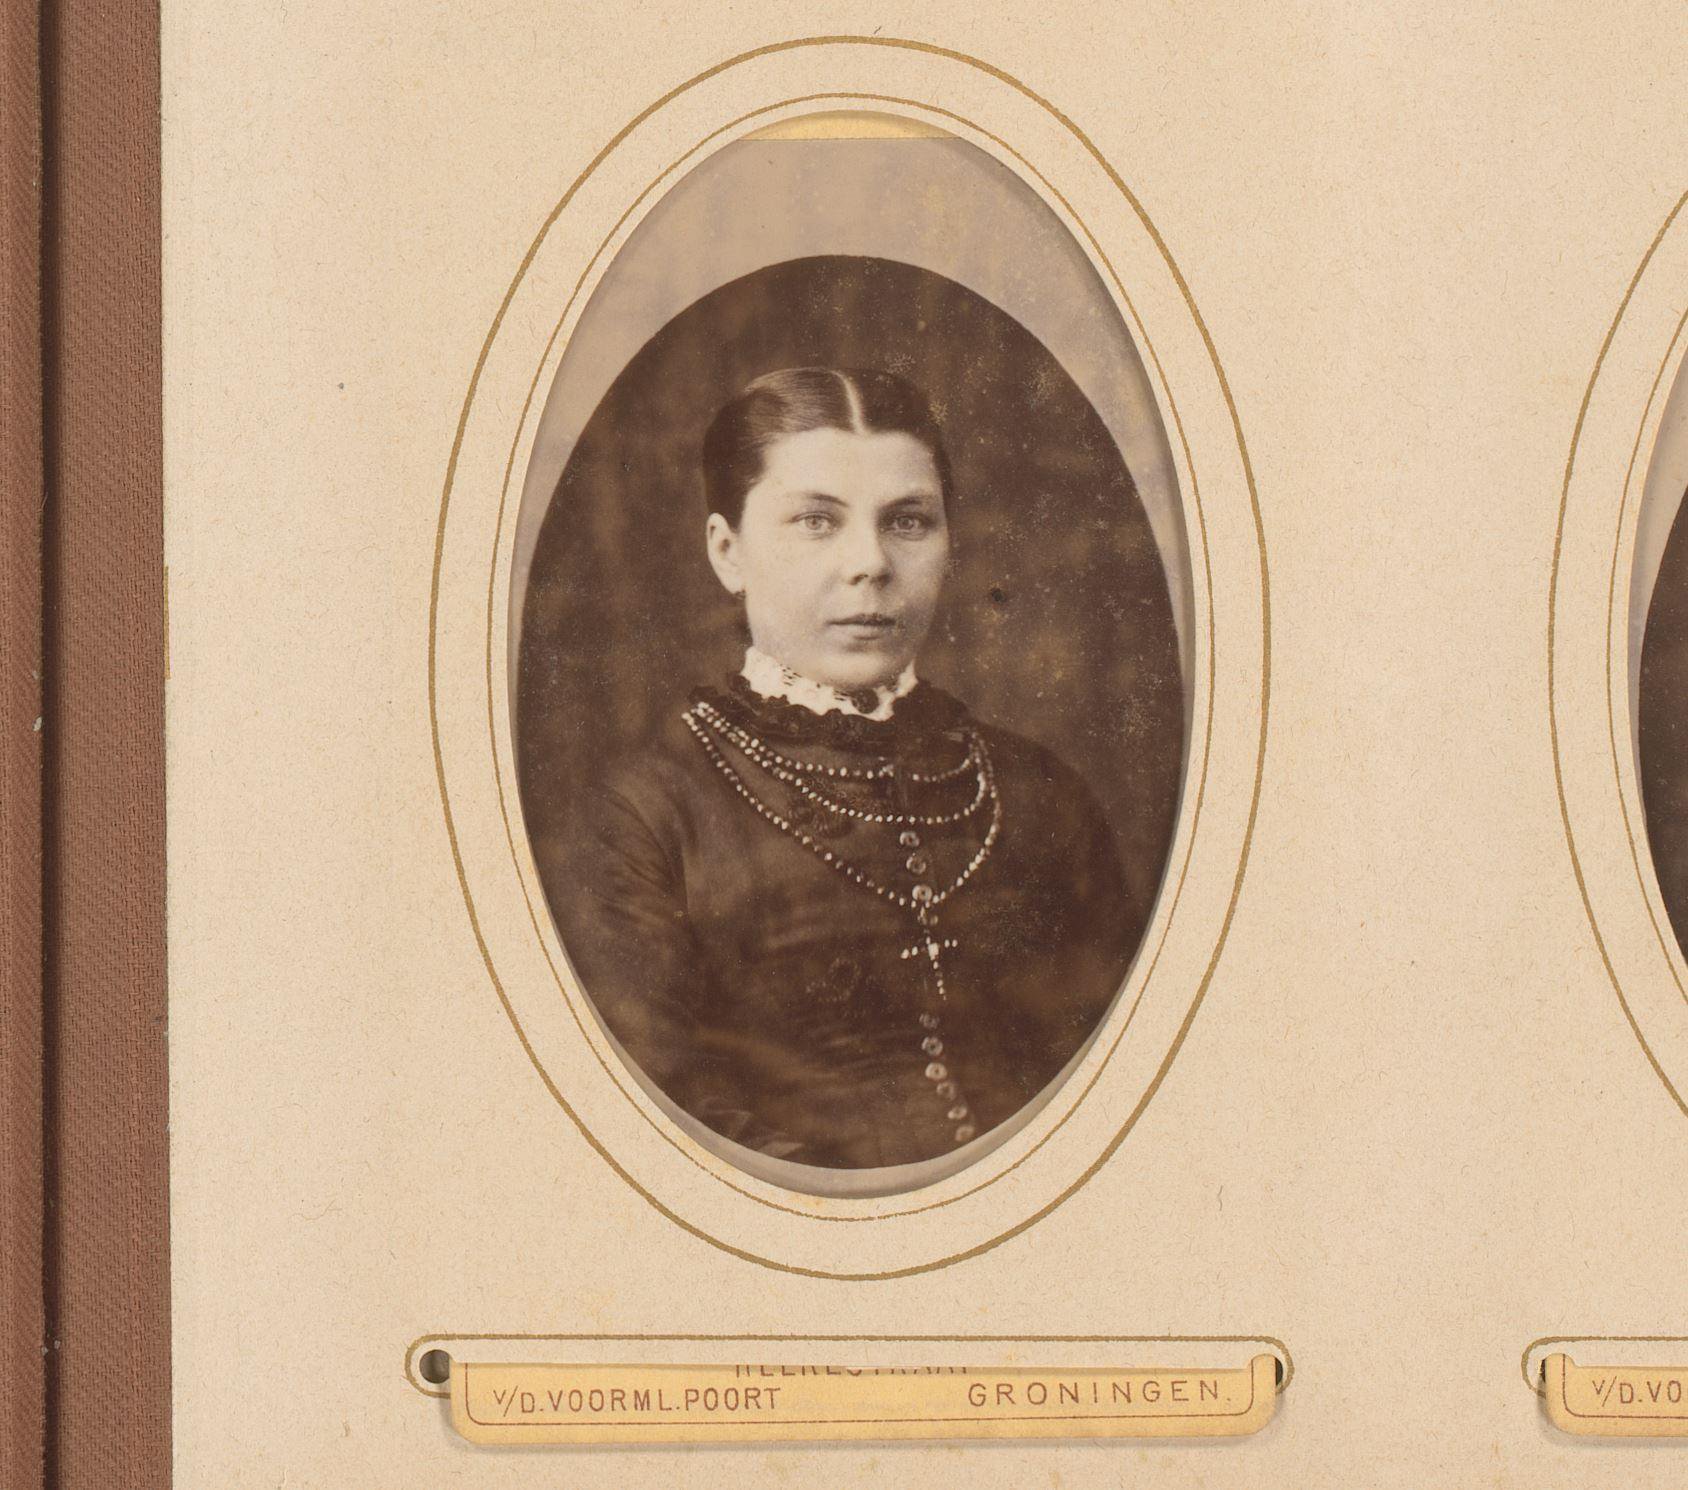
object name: album leaf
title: Portret van een vrouw met ketting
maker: benjamin sanders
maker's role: fotograaf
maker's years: 1841-1889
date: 1856-1889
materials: cardboard, photographic support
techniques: albumen print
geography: groningen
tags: historical persons - bb - woman, necklace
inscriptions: inscription: ‘Photographisch Atelier/ Benjamin Sanders/ Groningen/ Heerestraat v/d voorml. poort R.514’